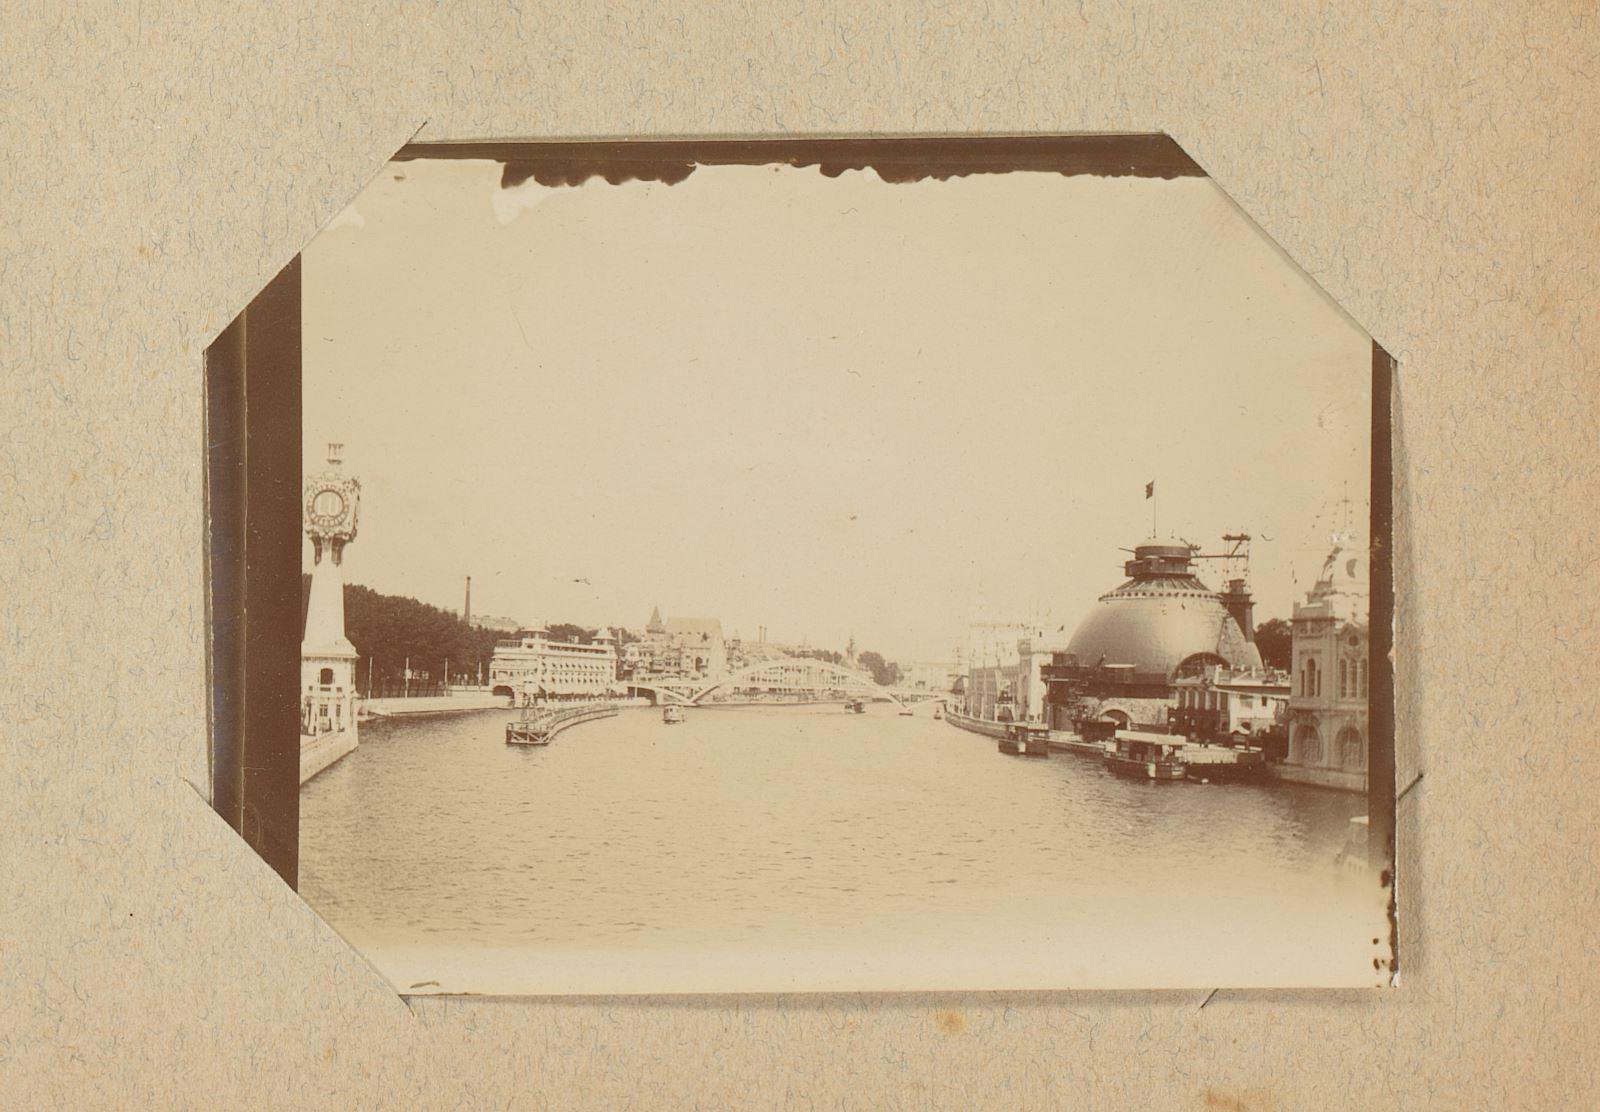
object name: photograph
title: Paviljoen van Creusot aan de Seine op de Wereldtentoonstelling van 1900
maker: Anonymous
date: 1900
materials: paper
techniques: gelatin silver print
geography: paris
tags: world fair, world exhibition, paris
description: Over de foto is een ander negatief afgedrukt van een voorstelling van bomen.